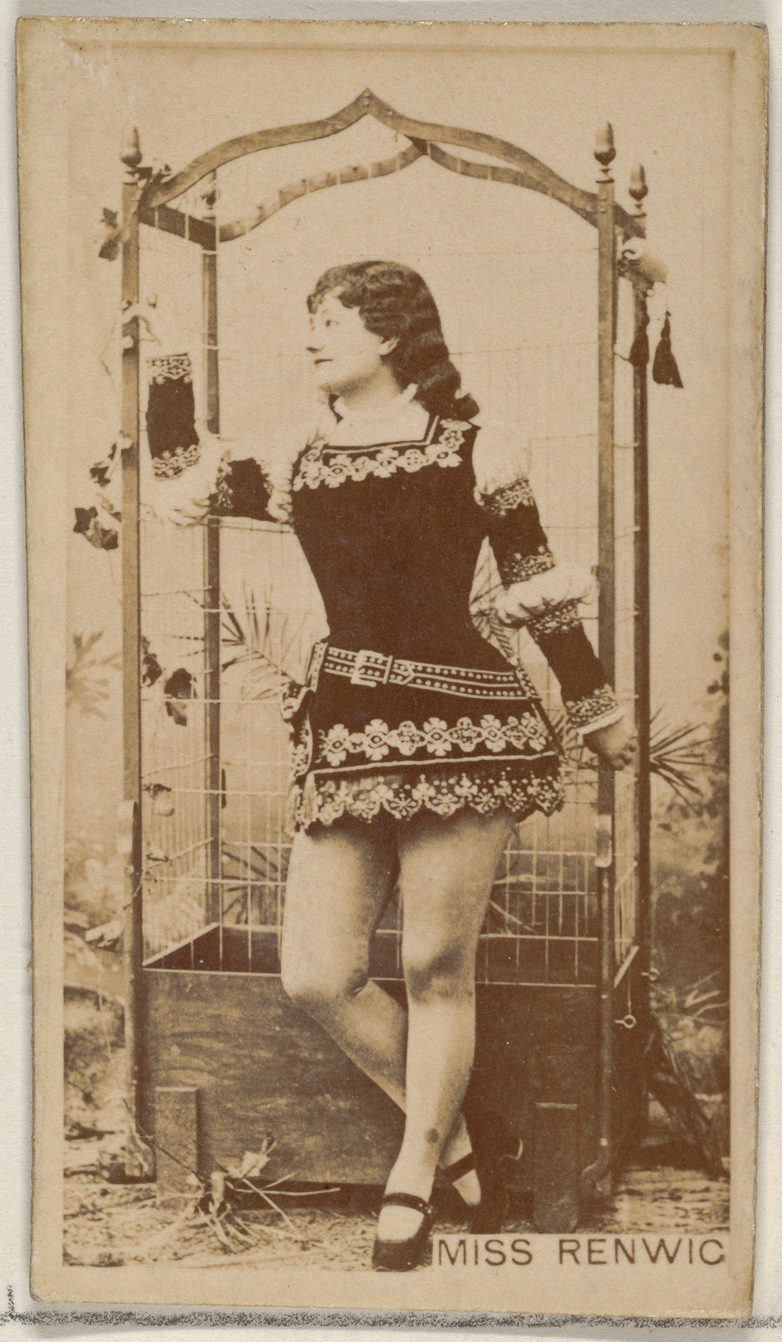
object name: photograph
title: Miss Renwic, from the Actors and Actresses series (N45, Type 8) for Virginia Brights Cigarettes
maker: allen & ginter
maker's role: publisher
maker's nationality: american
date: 1888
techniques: albumen silver print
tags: women,actresses